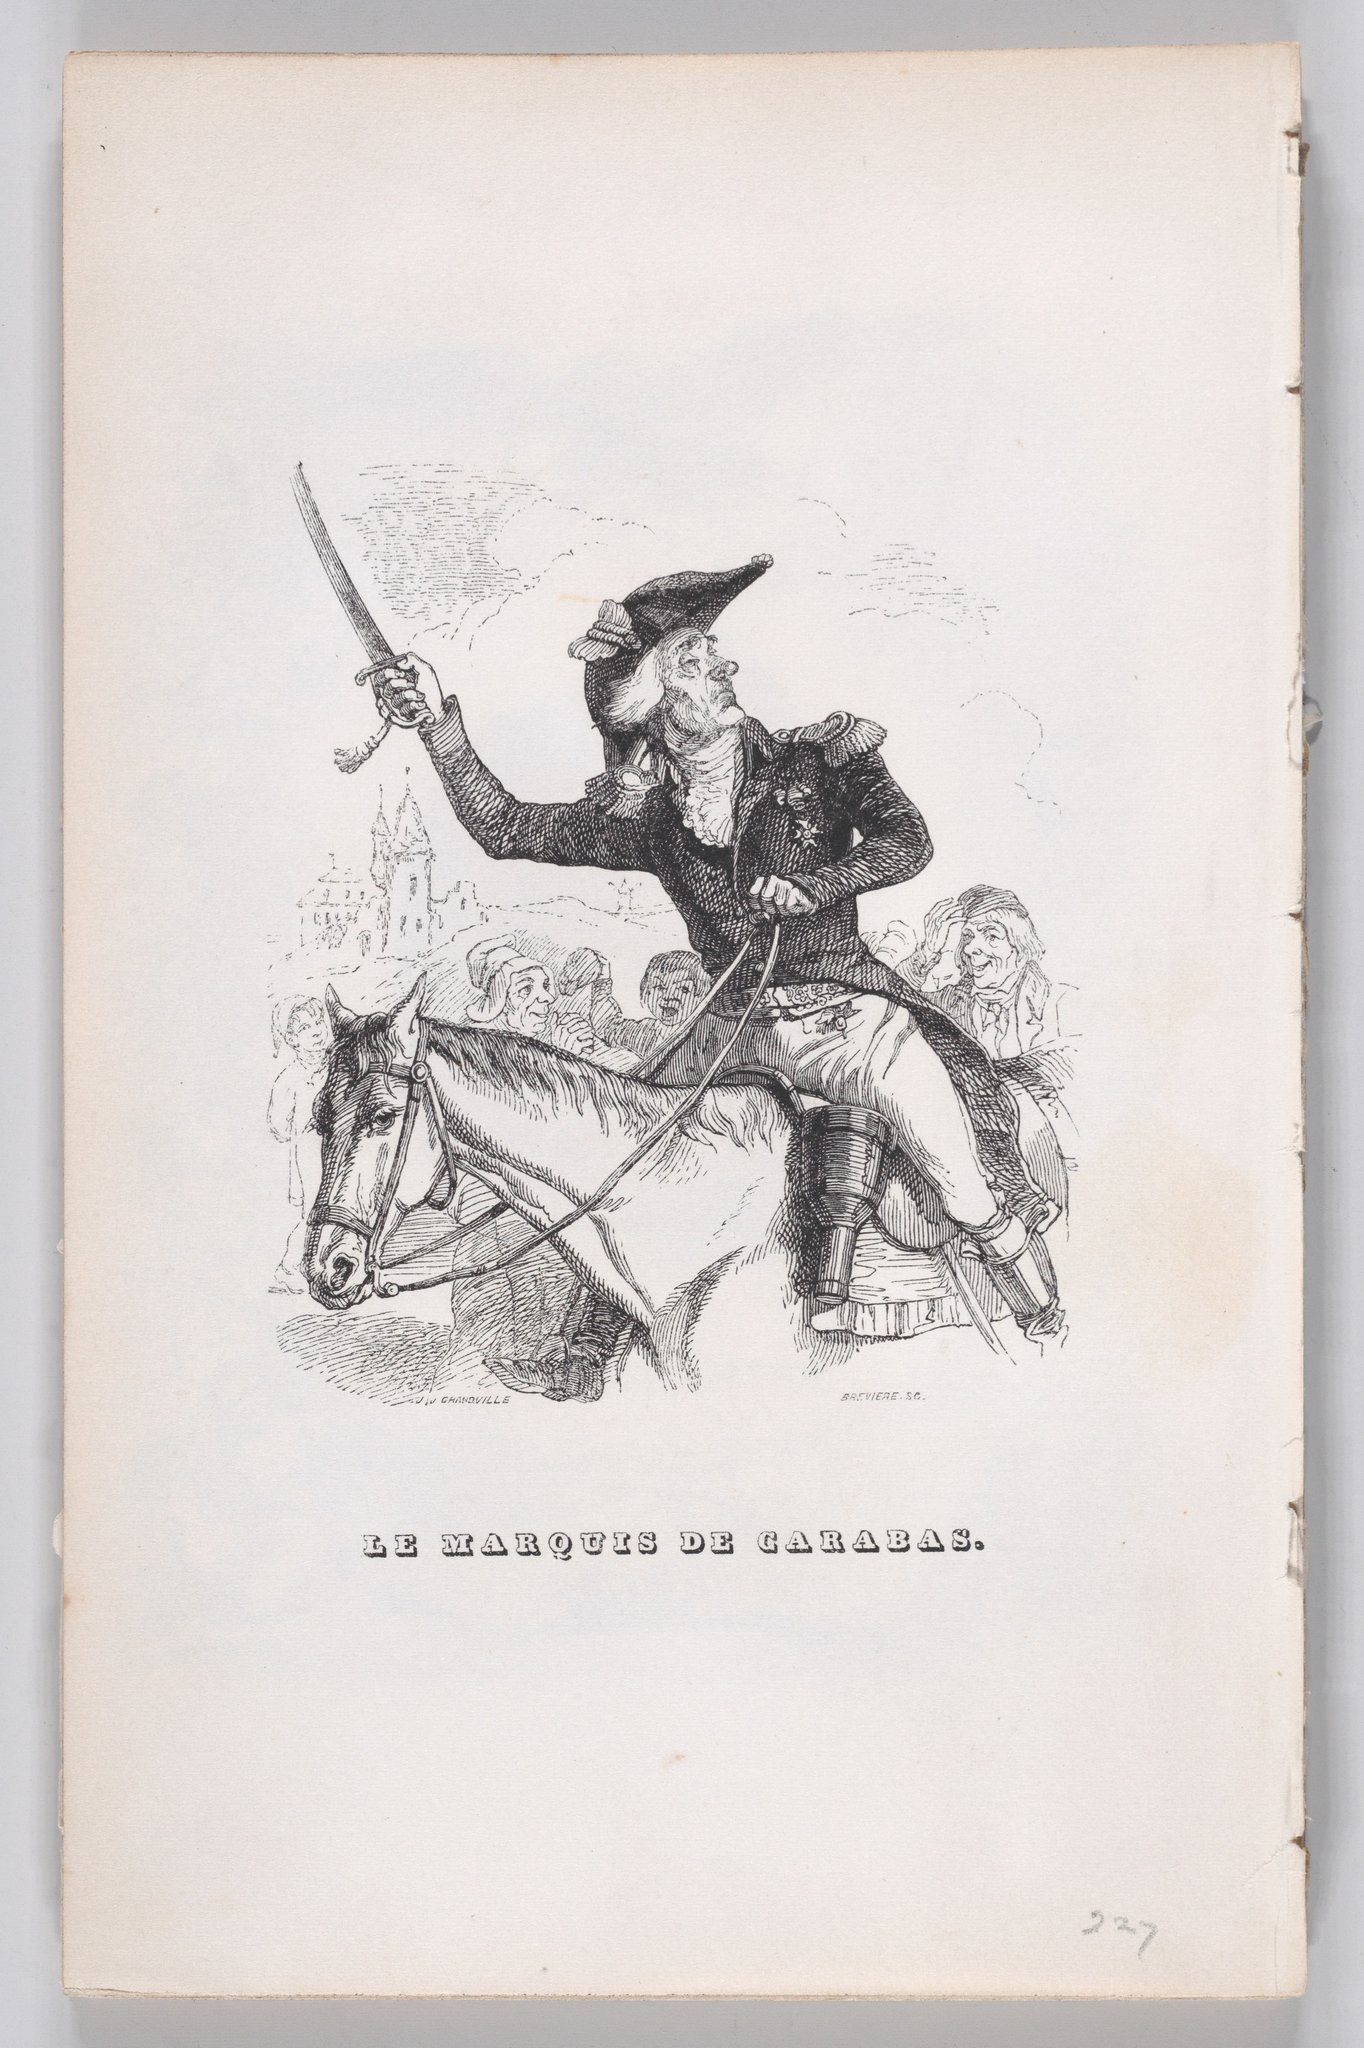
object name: print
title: The Marquis of Carabas, from "The Complete Works of Béranger"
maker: j. j. grandville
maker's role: illustrator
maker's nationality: french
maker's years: 1803-1847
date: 1836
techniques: engraving